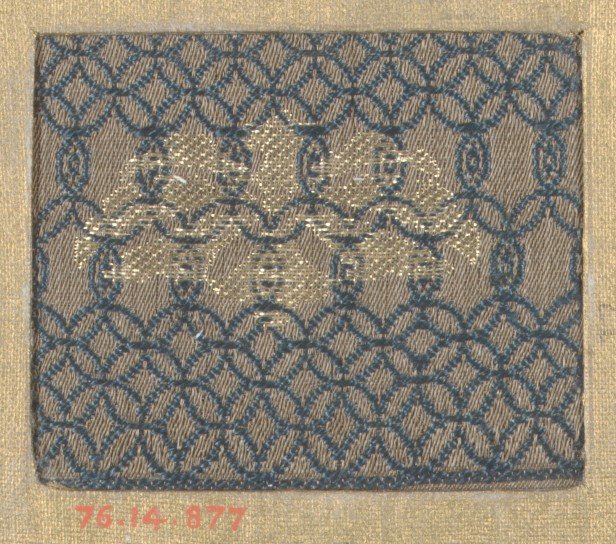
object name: piece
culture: japanese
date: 1701-1900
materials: silk